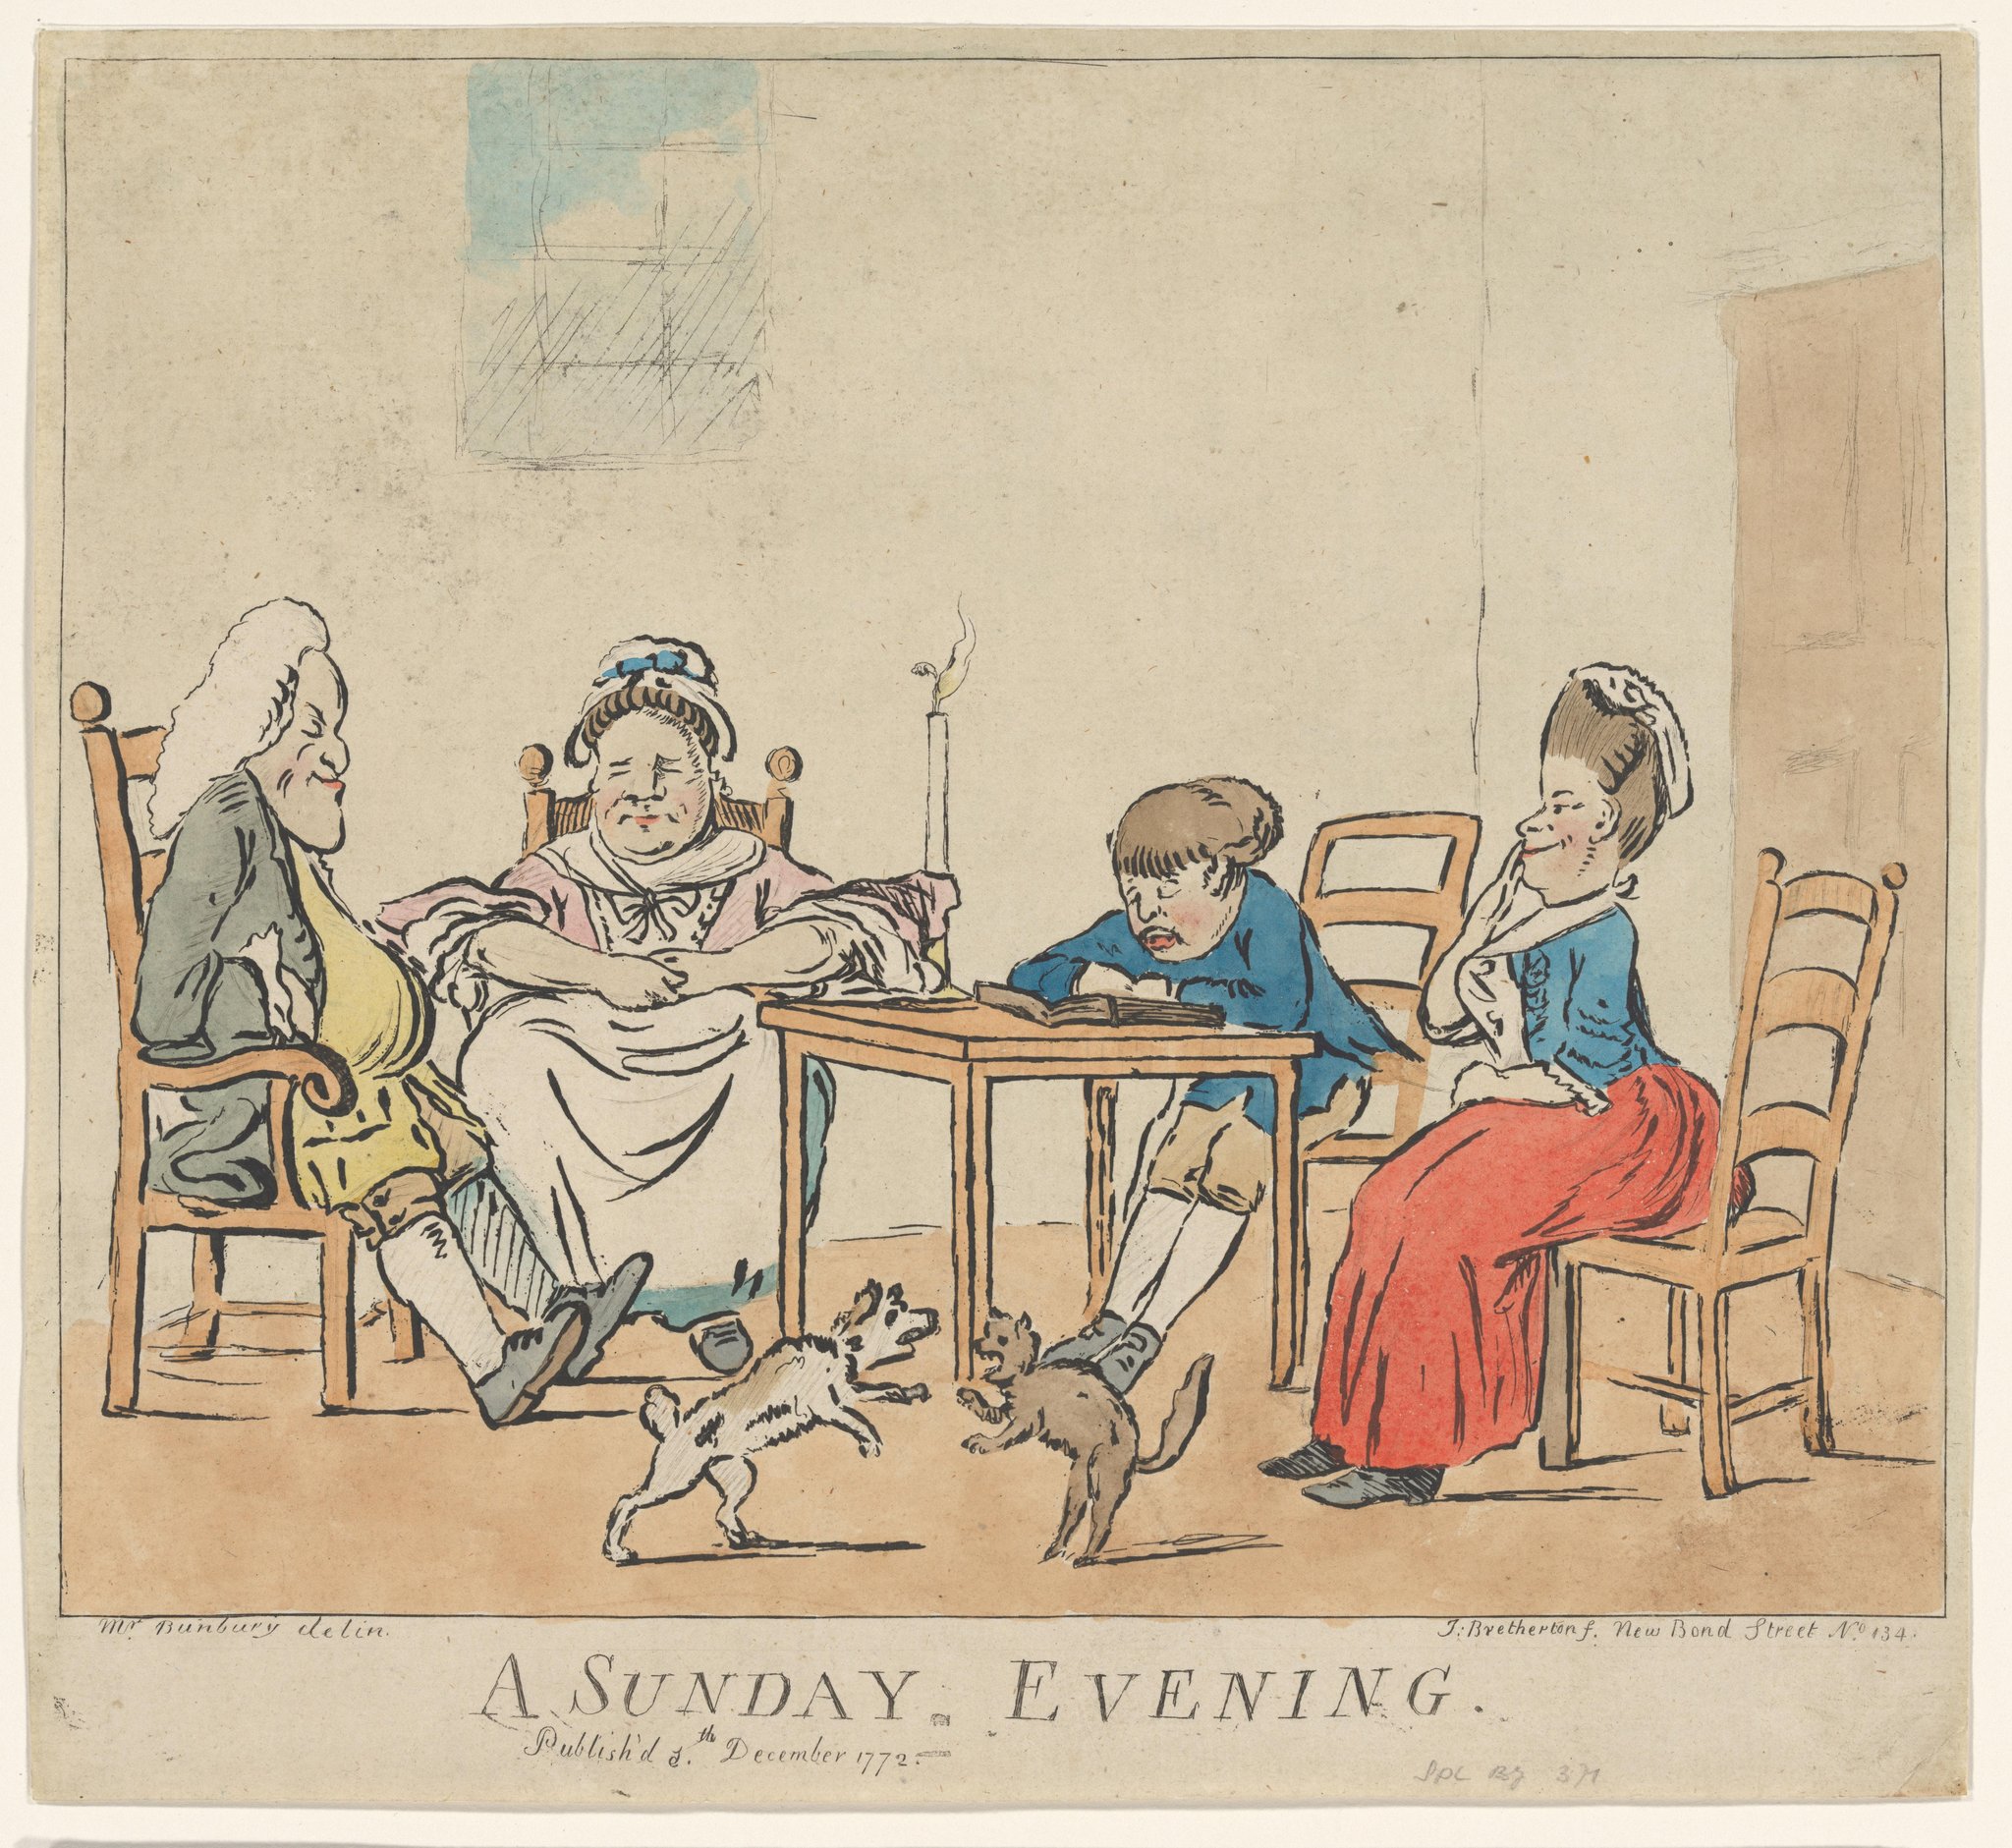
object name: cartoon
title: A Sunday Evening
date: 1772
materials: paper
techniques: etching, hand coloring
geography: london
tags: sleeping in chair, cat, family group, especially parents with their child(ren), family life at home, sunday, dog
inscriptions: collector's mark: Lugt 2228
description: Een oudere man zit links in een houten leunstoel te slapen. Rechts naast hem zit zijn vrouw te slapen in haar stoel, haar handen in elkaar gevouwen, haar linker elleboog steunend op een tafel. Aan de tafel zit een jongen die in slaap is gevallen tijdens het lezen van een boek. Rechts zit een vrouw van middelbare leeftijd, rechtop op het puntje van haar stoel. De vrouw lacht om de situatie. Op de voorgrond vechten een hond en een kat. De kamer wordt verlicht door een brandende kaars op de tafel.